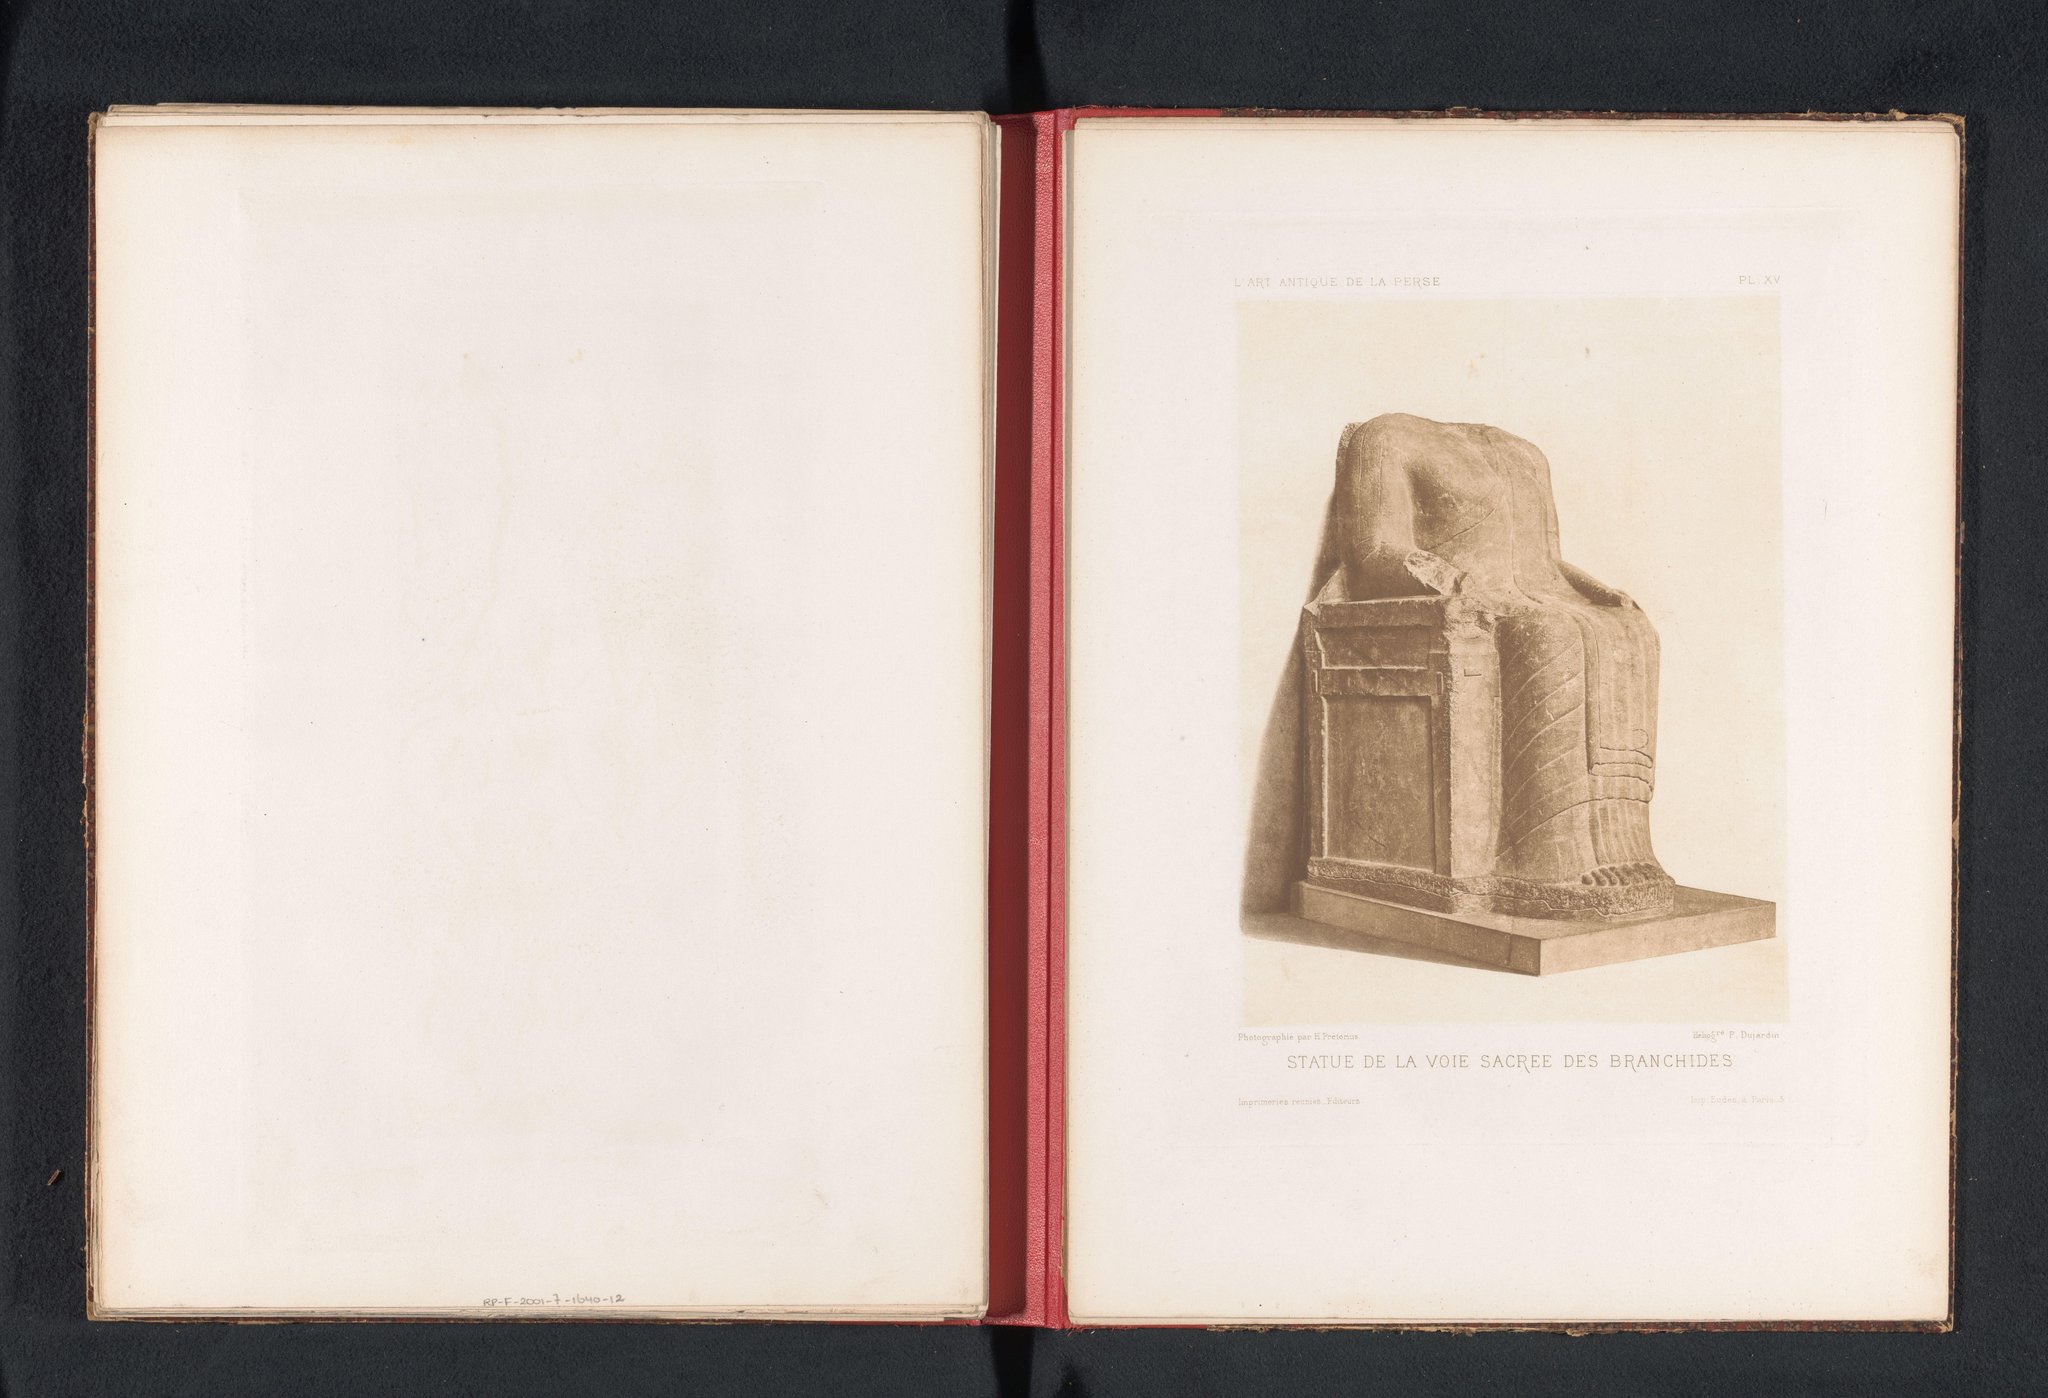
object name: photomechanical print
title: Sculptuur van een zittende figuur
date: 1880-1885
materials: paper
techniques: photoaquatint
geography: paris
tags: sitting figure, piece of sculpture, reproduction of a piece of sculpture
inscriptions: number: ‘PL. XV’, inscription: ‘Imprimeries réunies_Editeurs. Imp. Eudes, à Paris_3.’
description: Deze prent maakt deel uit van een omslag met twintig prenten op zeventien bladen en vijftien tekstbladen.